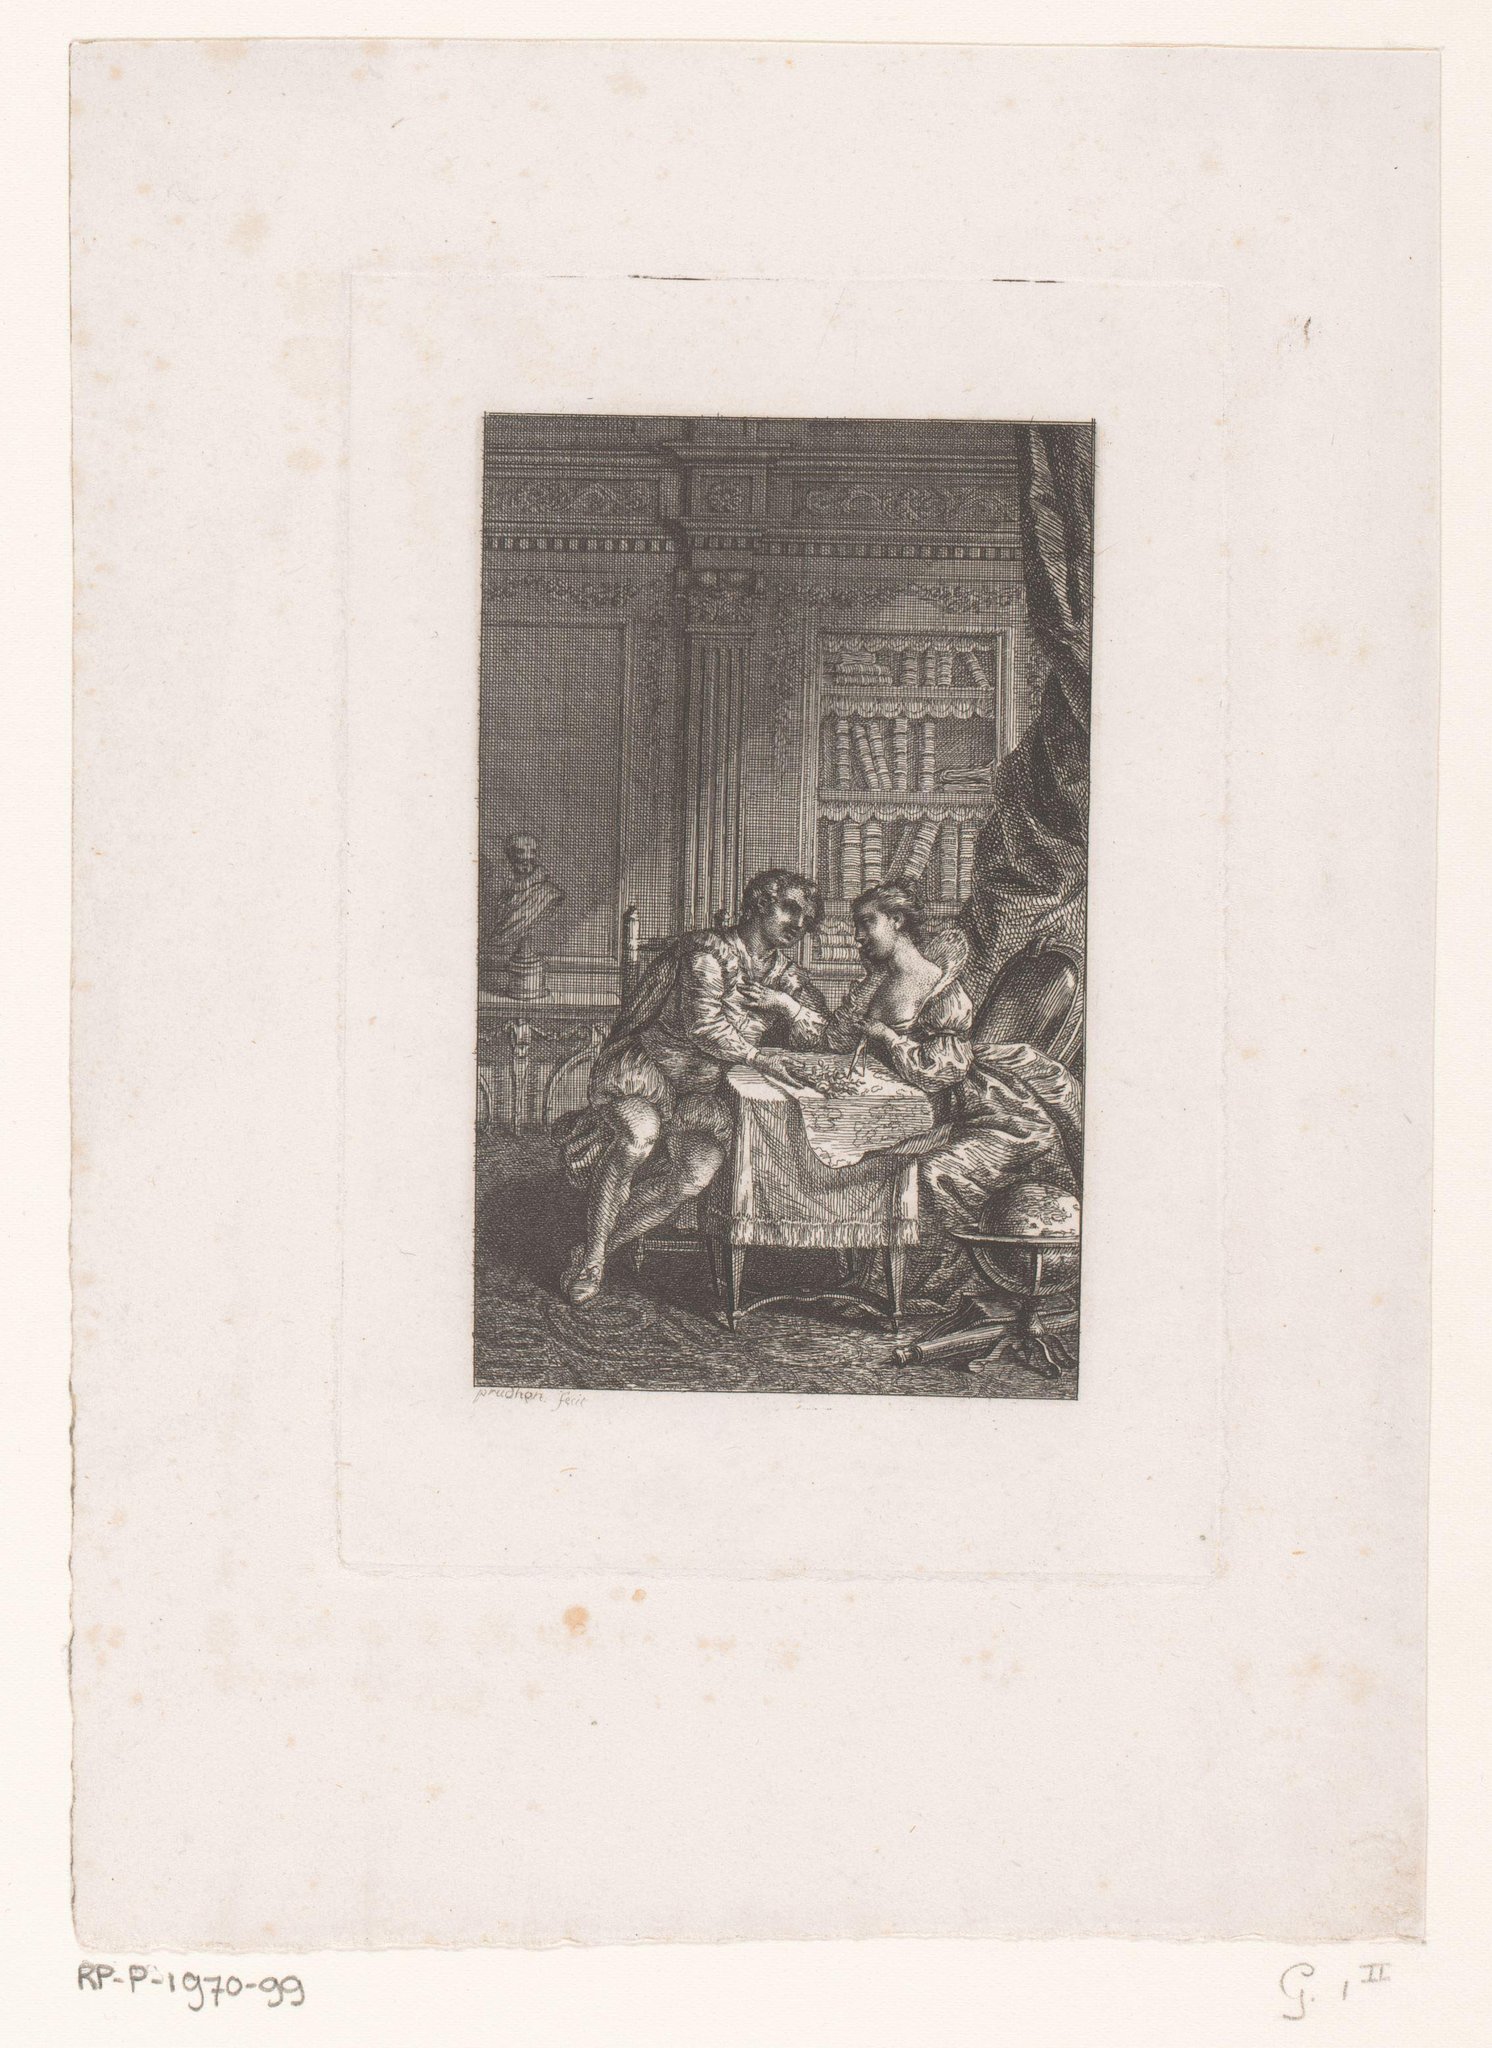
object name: print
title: La Leçon de botanique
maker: pierre prudhon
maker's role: draughtsman, painter, print maker, publisher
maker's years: 1758-1823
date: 1768-1823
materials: paper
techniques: etching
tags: study; 'studiolo'; library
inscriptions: collector's mark: Lugt 2228, collector's mark: Lugt 2760